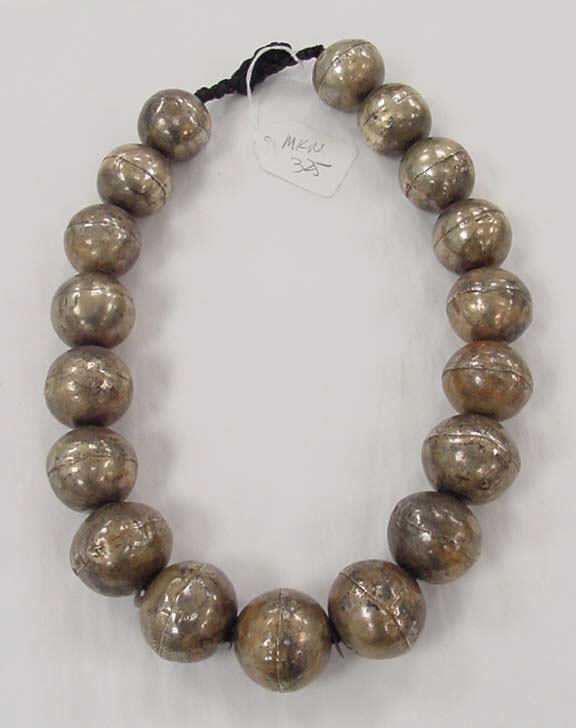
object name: necklace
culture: indigenous american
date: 800-1400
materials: cotton, metal